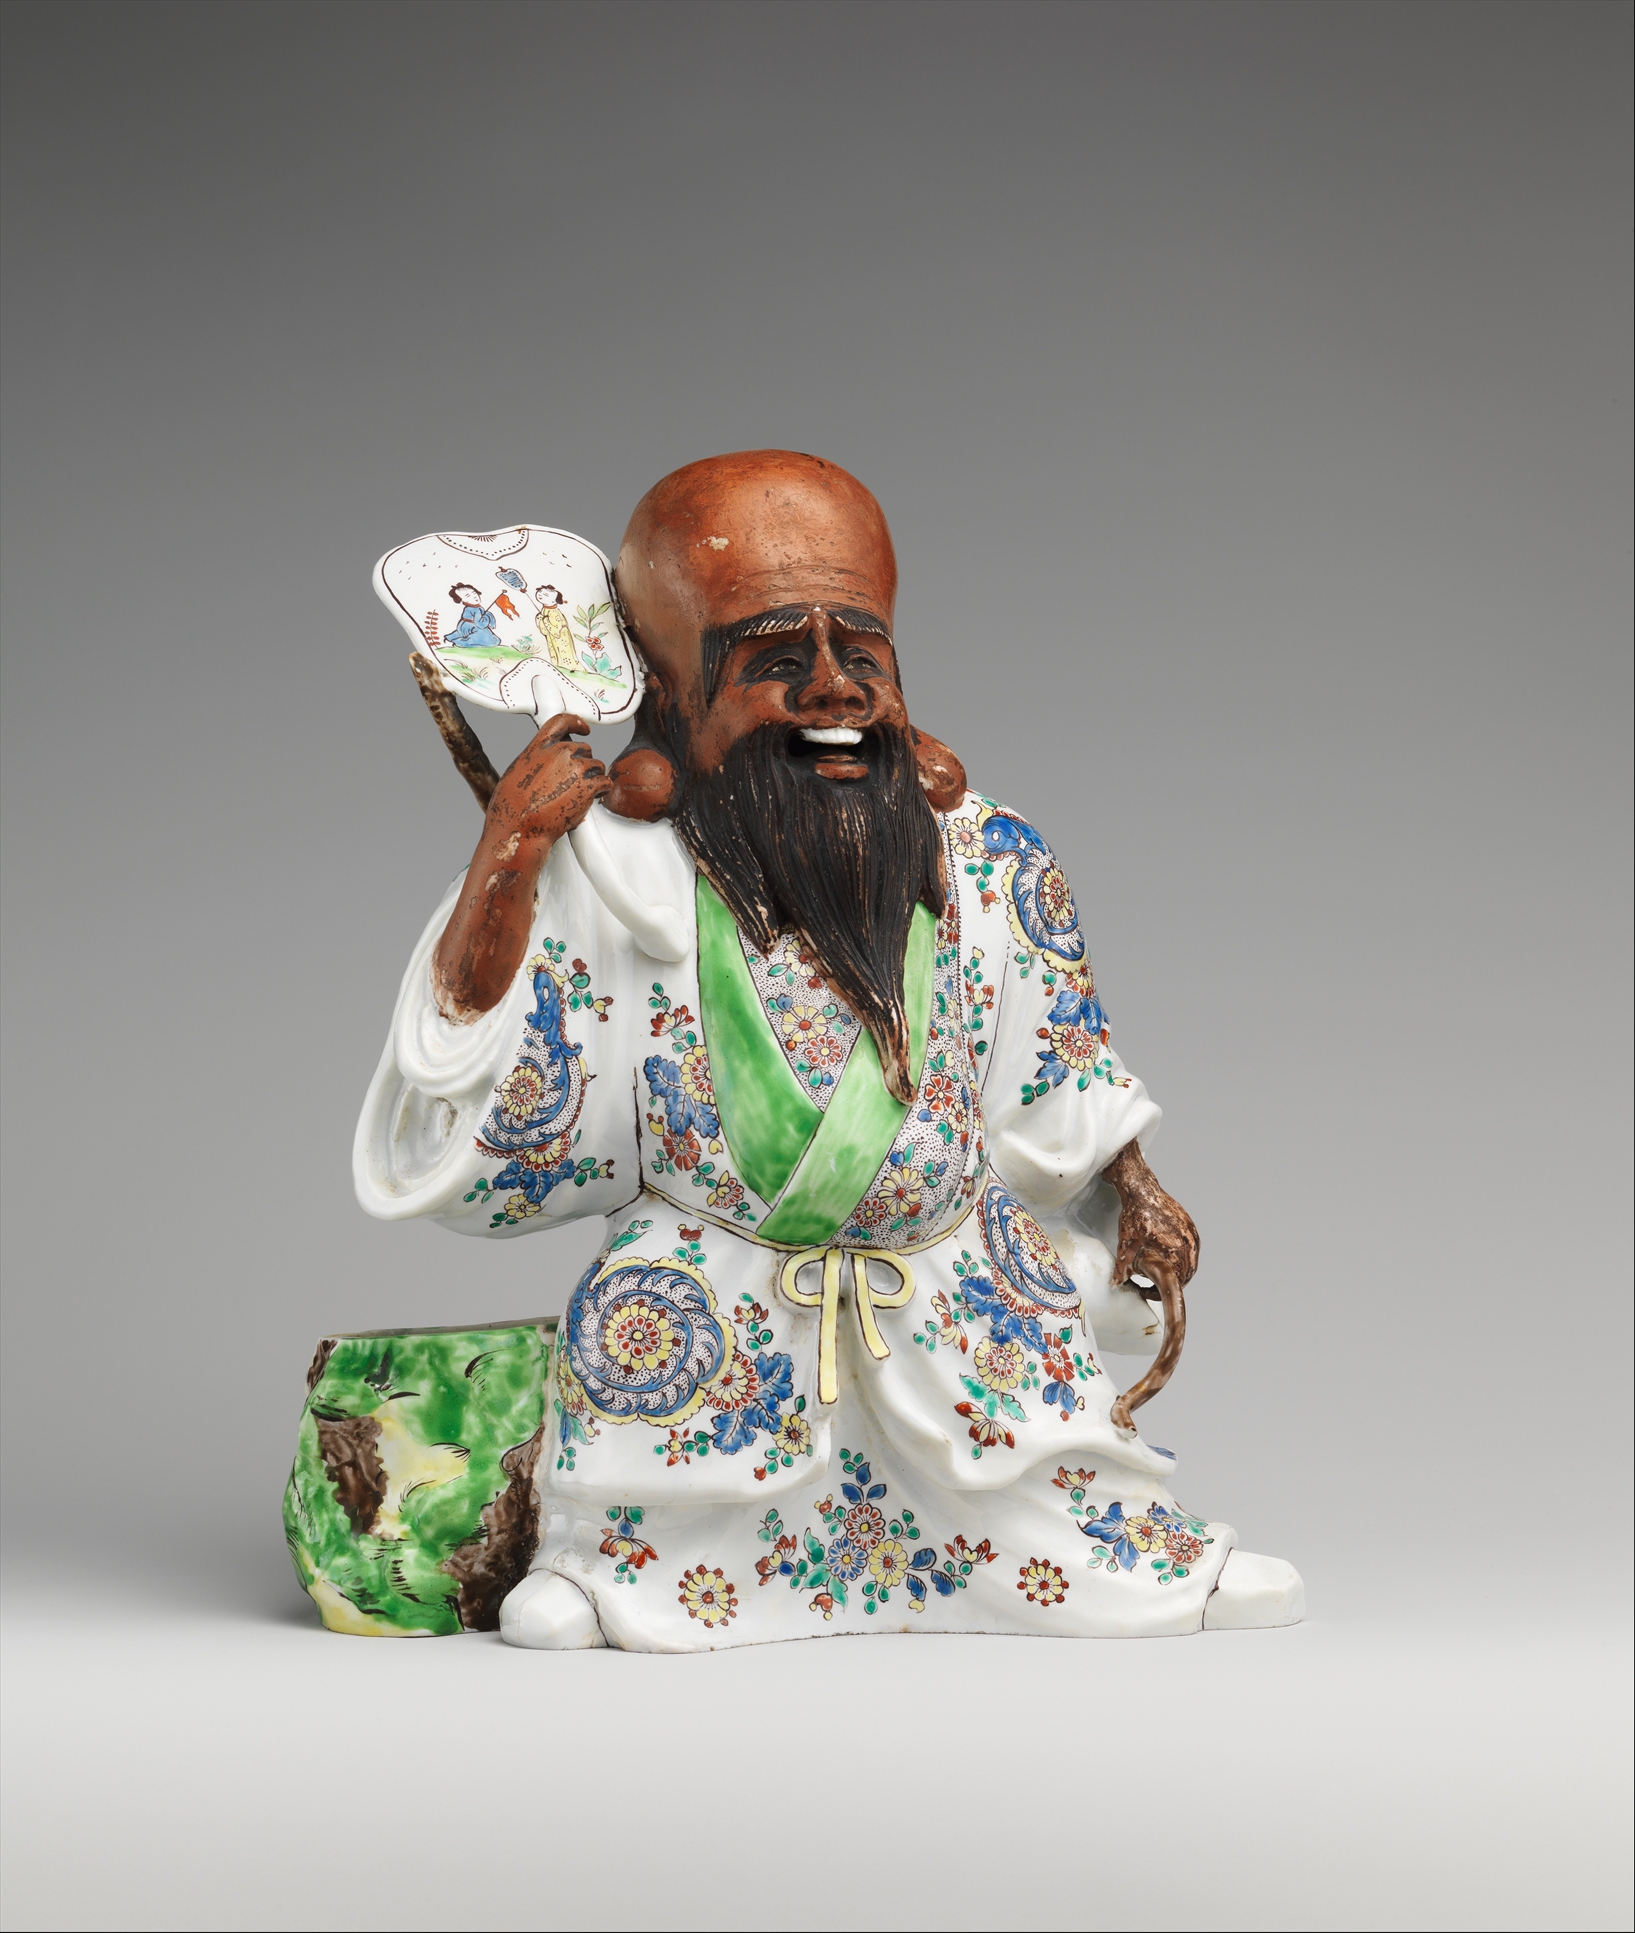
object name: figure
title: Shoulao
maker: chantilly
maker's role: factory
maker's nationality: french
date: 1735-1740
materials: enamel, soft paste porcelain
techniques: polychrome, glazing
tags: fans,men,gods